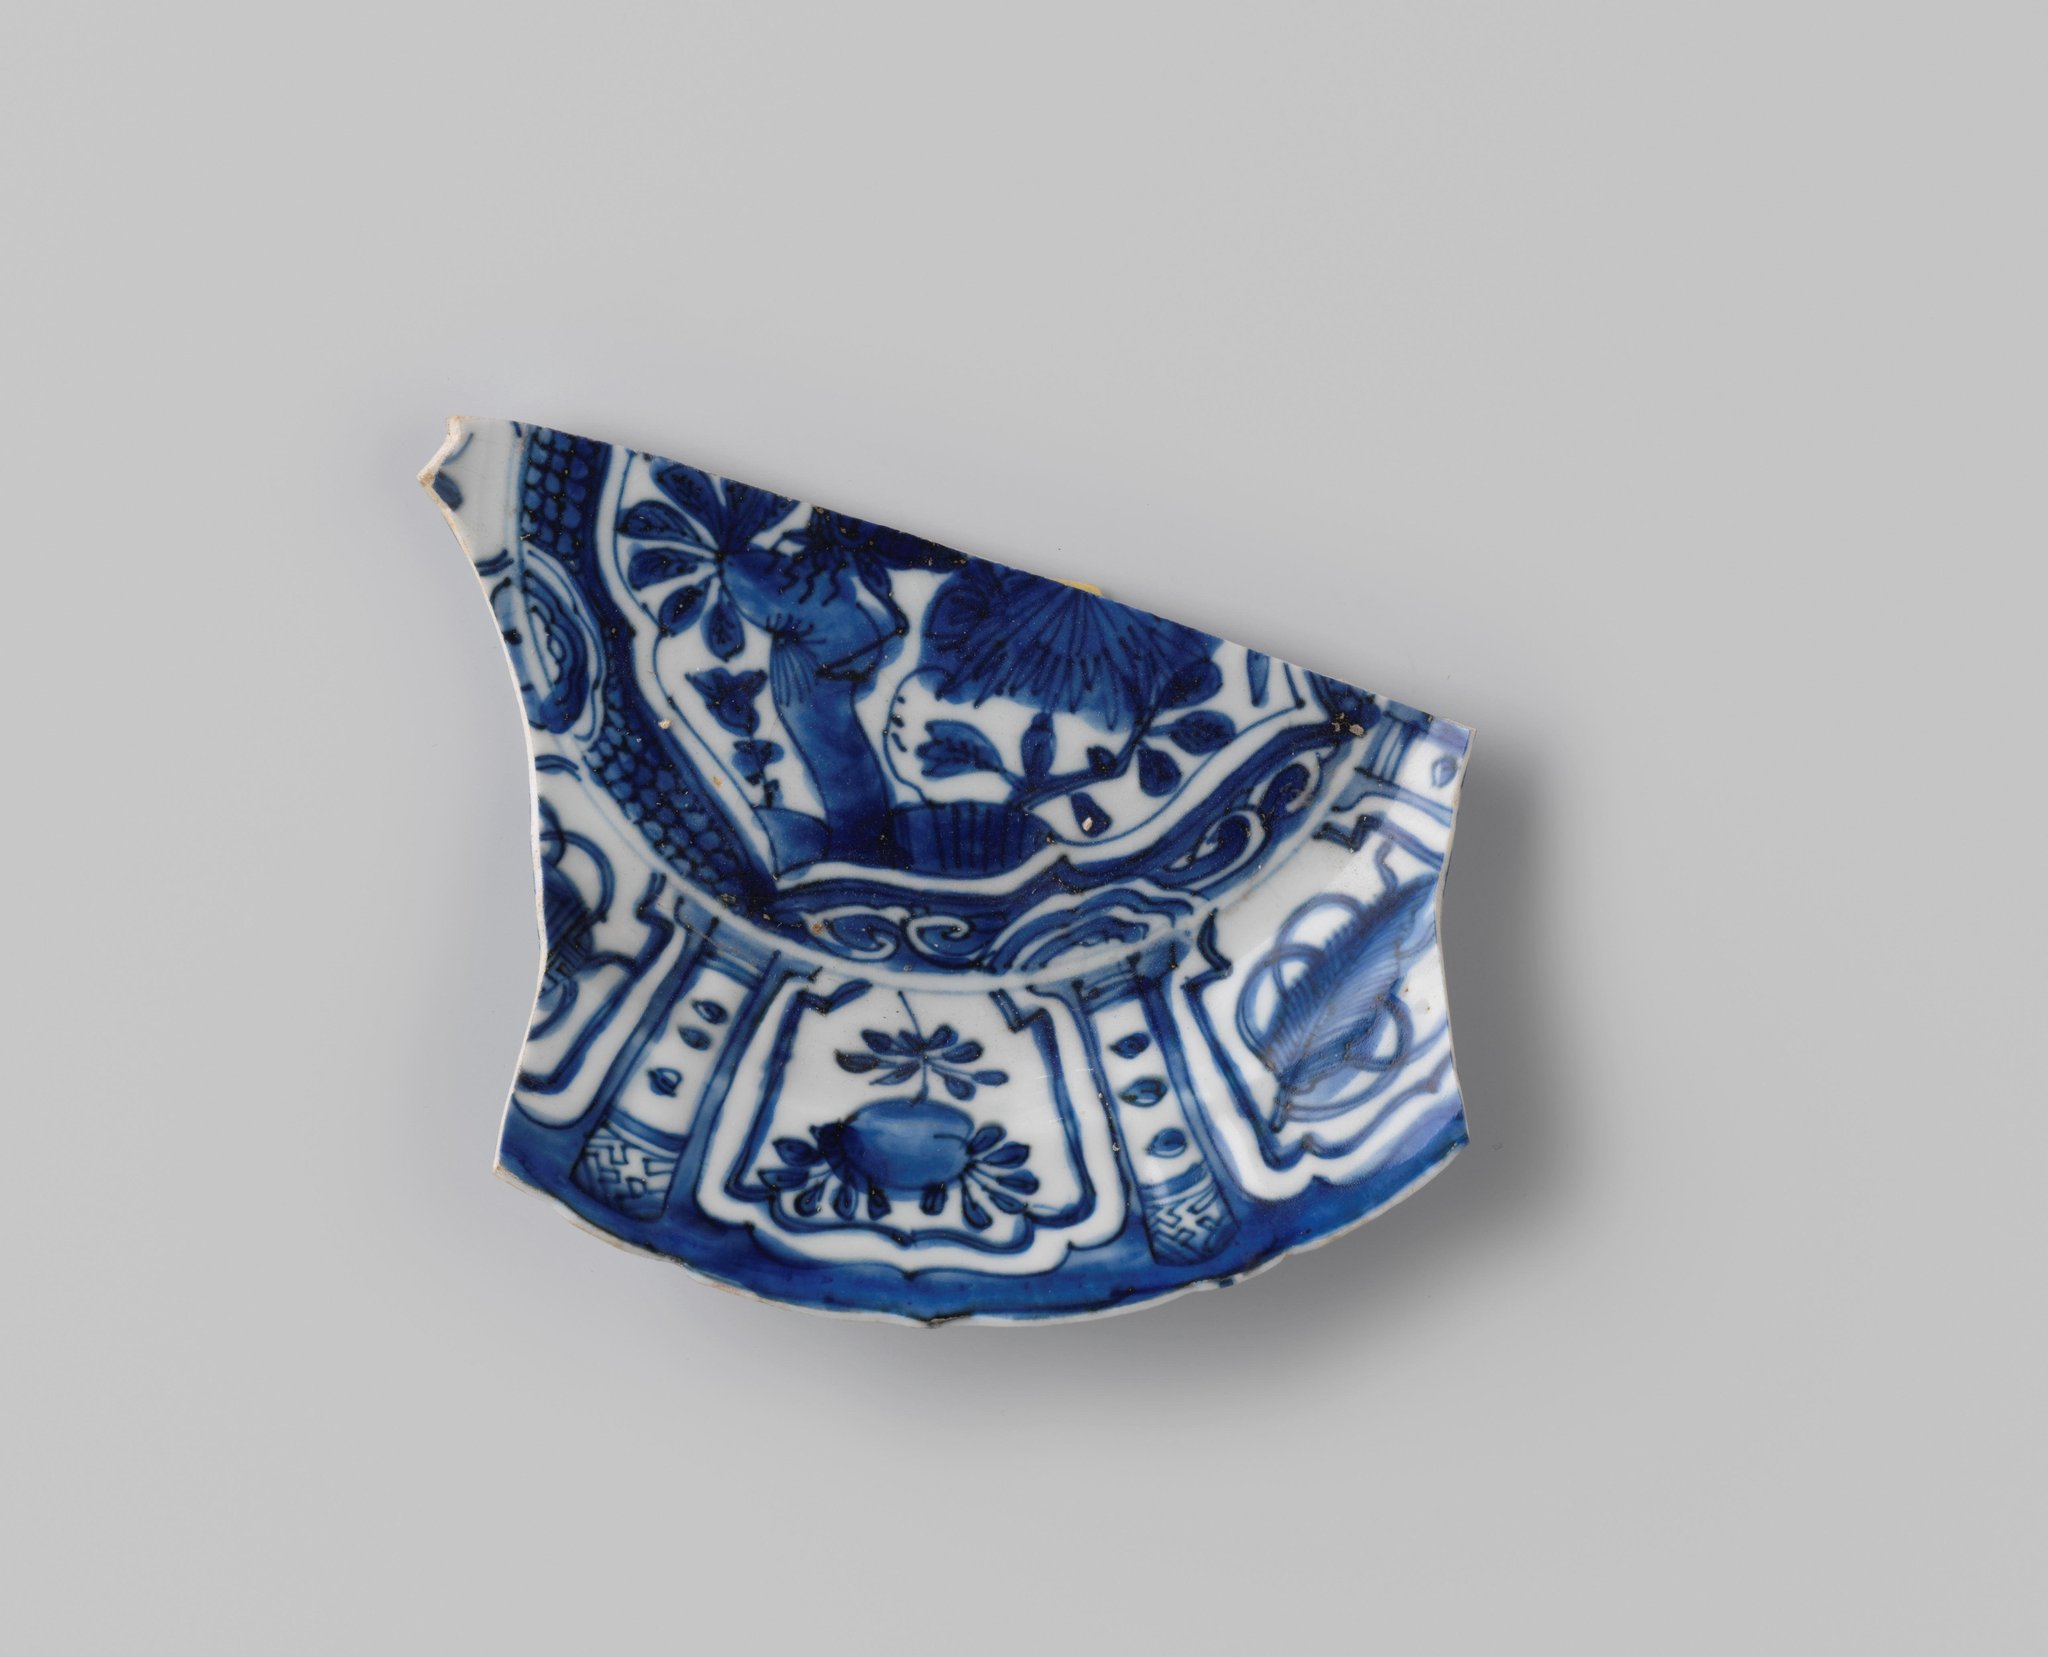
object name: sherd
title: Fragment bord uit V.O.C.-schip de 'Witte Leeuw'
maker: Anonymous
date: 1613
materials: bone china, porcelain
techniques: painted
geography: jingdezhen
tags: verenigde oostindische compagnie, sint-helena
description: A plate with a flattened rim. A star-shaped medallion with 4 rui heads and various diaper patterns. These plates all have a central decoration of symbols; the decoration on cavetto and rim are also similar. Another typical feature of these plates is the pattern resembling the imprint of woven cloth in the centre, under the glaze. A central decoration of an insect on a rock. Panels decorated with peaches and symbols.